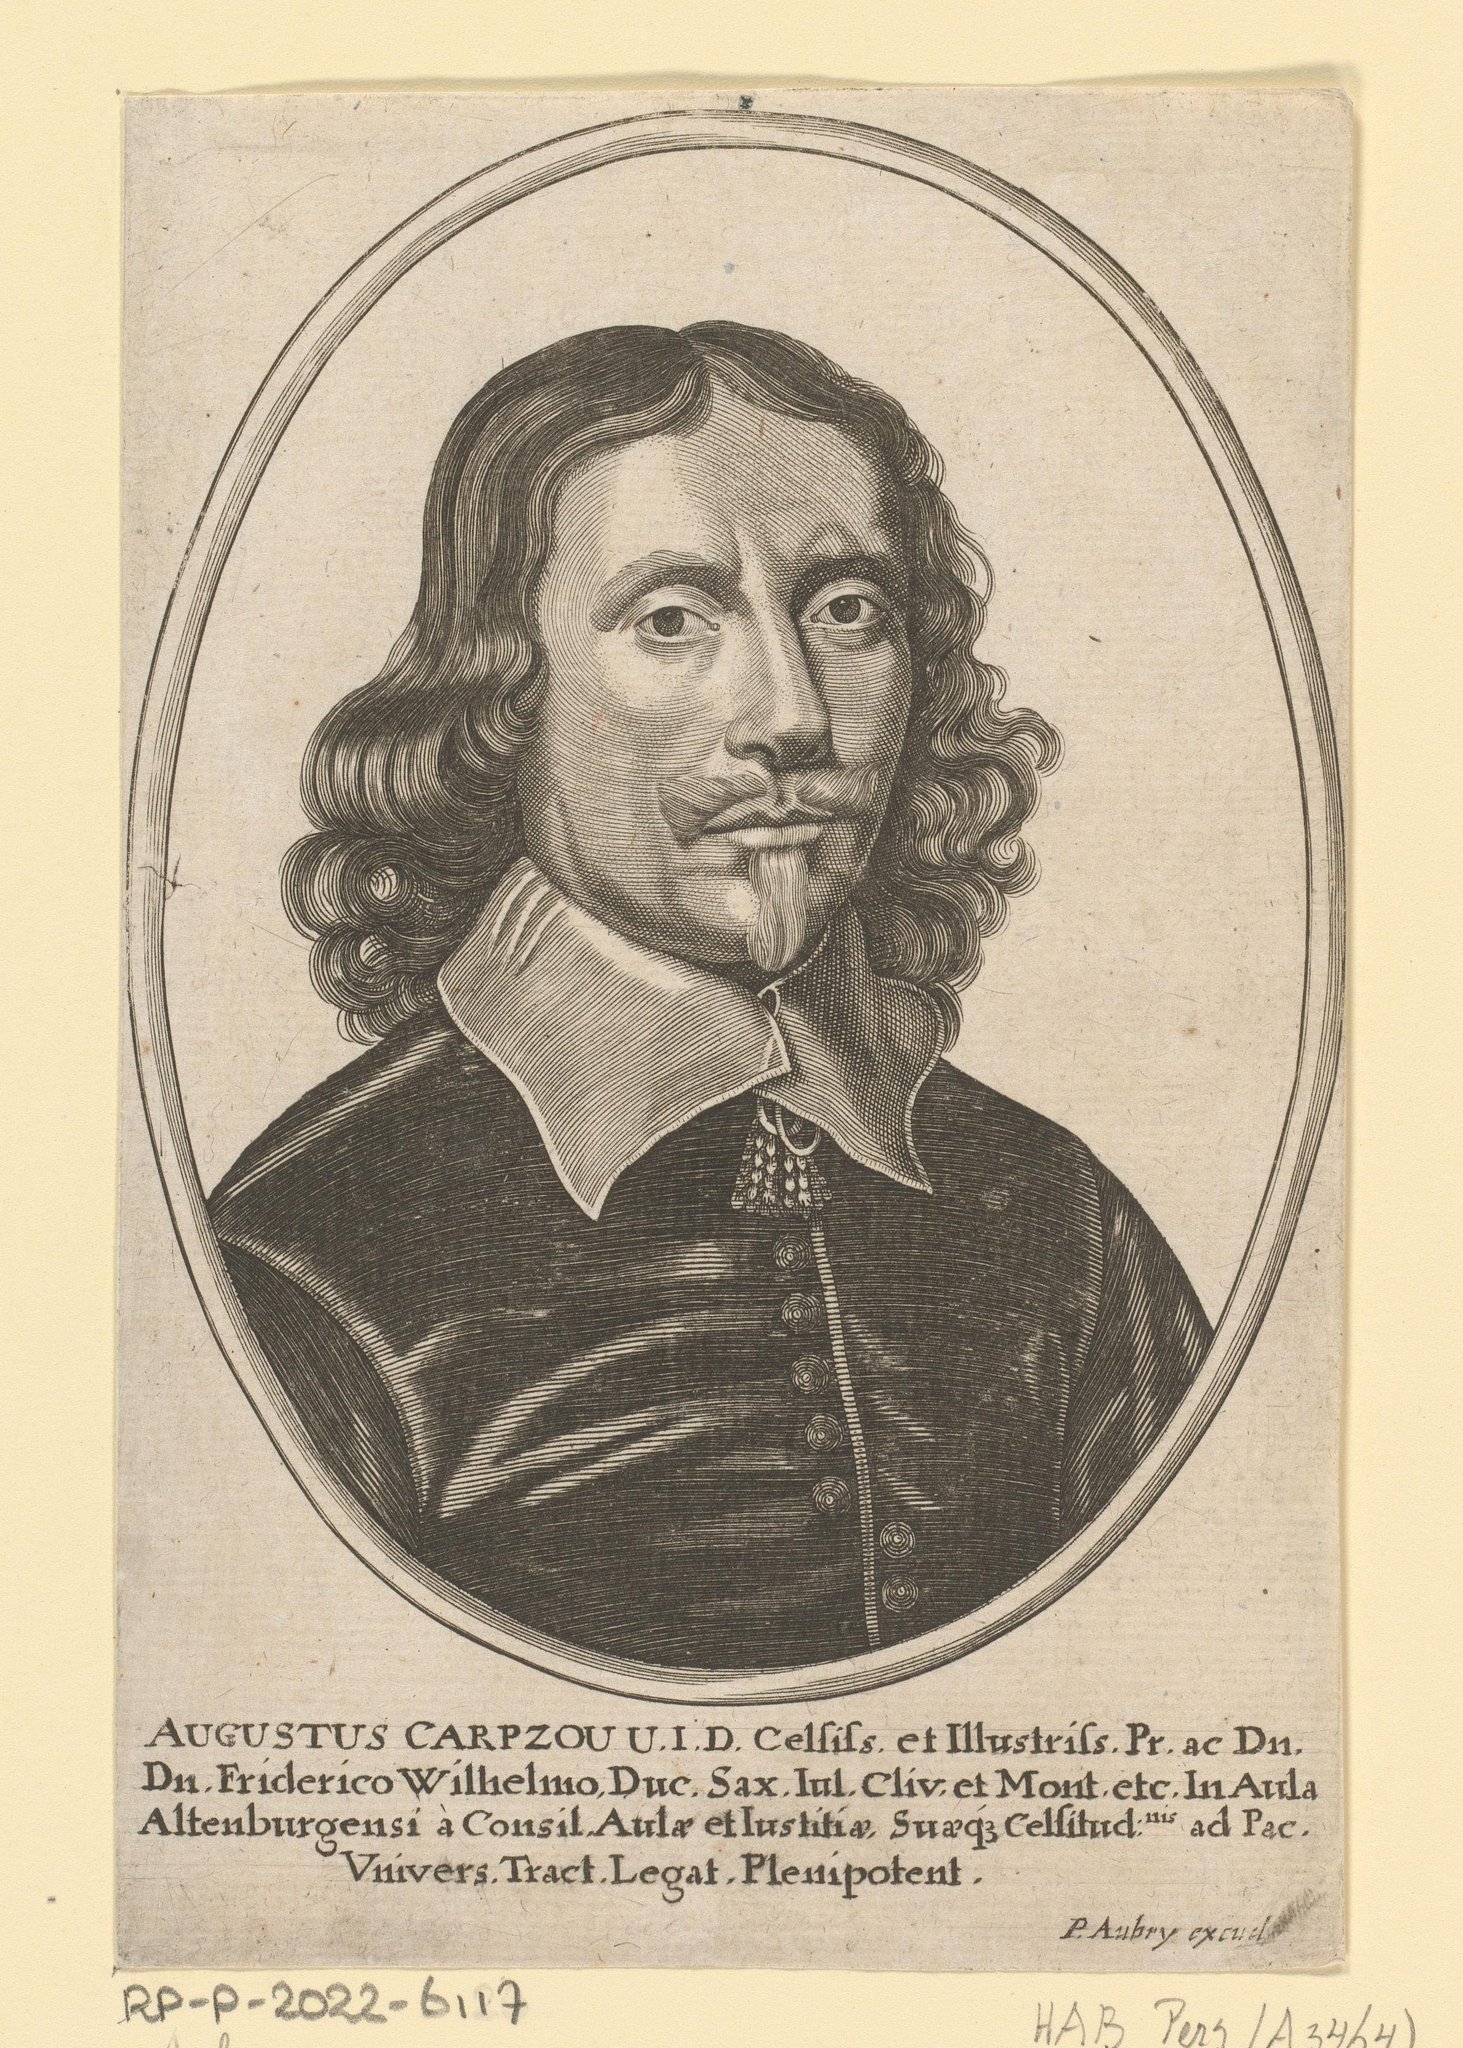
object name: print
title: Portretten van afgevaardigden bij de Vrede van Westfalen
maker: Anonymous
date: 1648-1650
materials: paper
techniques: engraving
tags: historical persons, lawyer, attorney at law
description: Met vierregelig onderschrift in het Latijn.